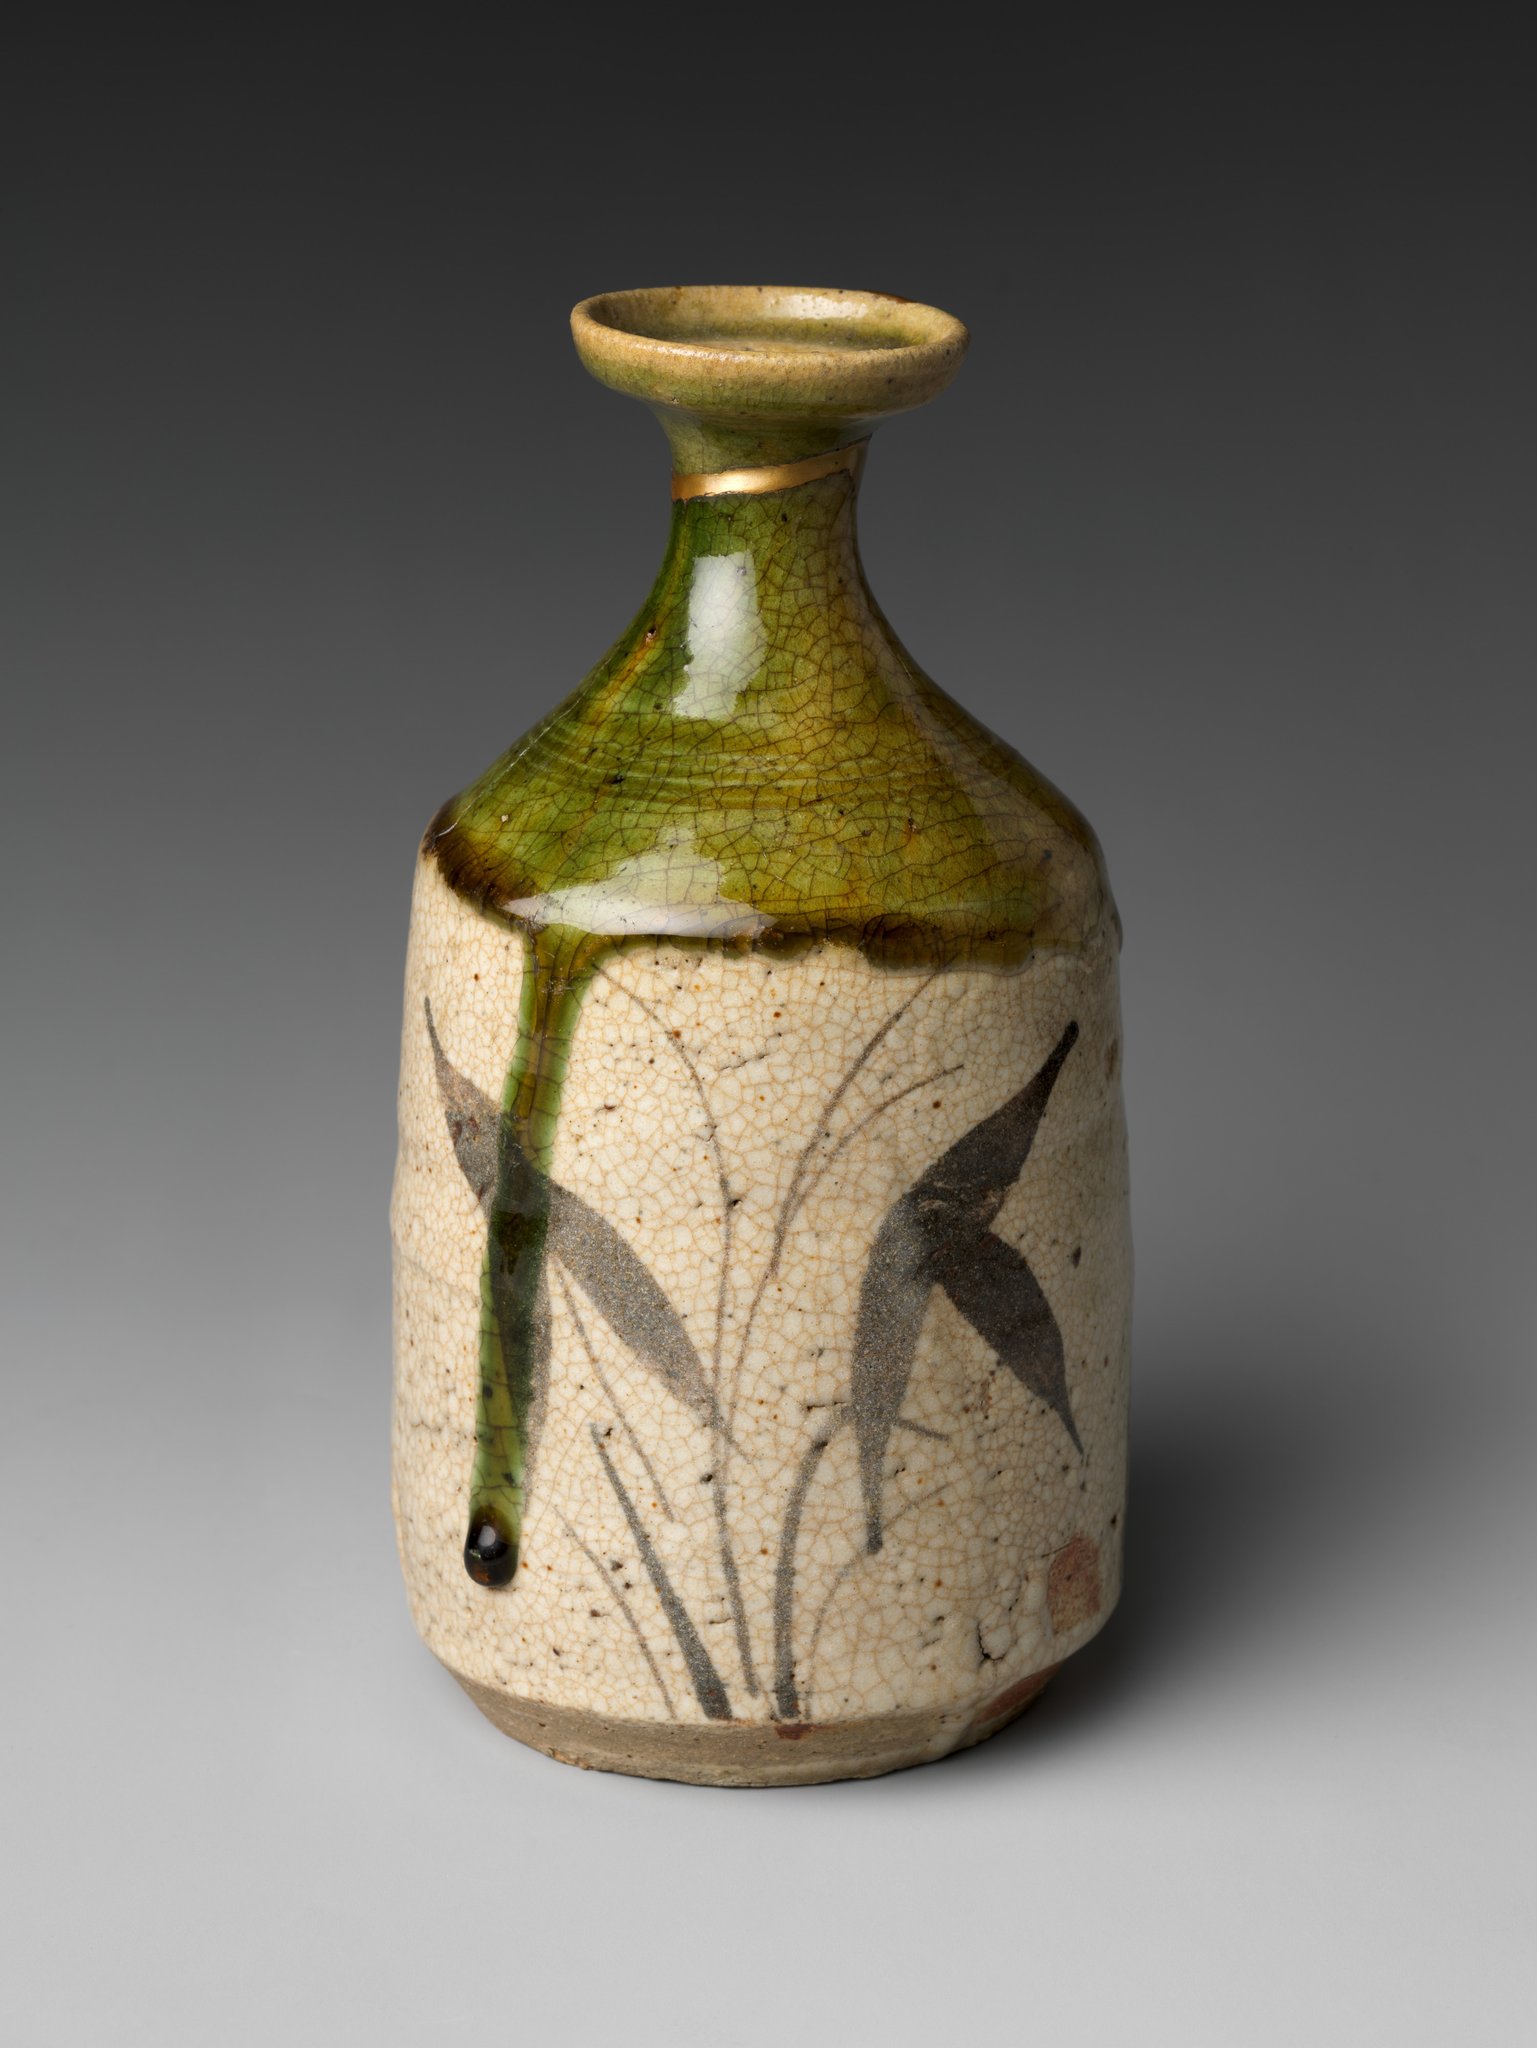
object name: sake bottle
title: Sake Bottle (Tokkuri) with Decoration of Three-Leaf Arrowhead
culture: japanese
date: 1601-1633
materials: copper, glaze, iron, stoneware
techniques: incising, underglaze